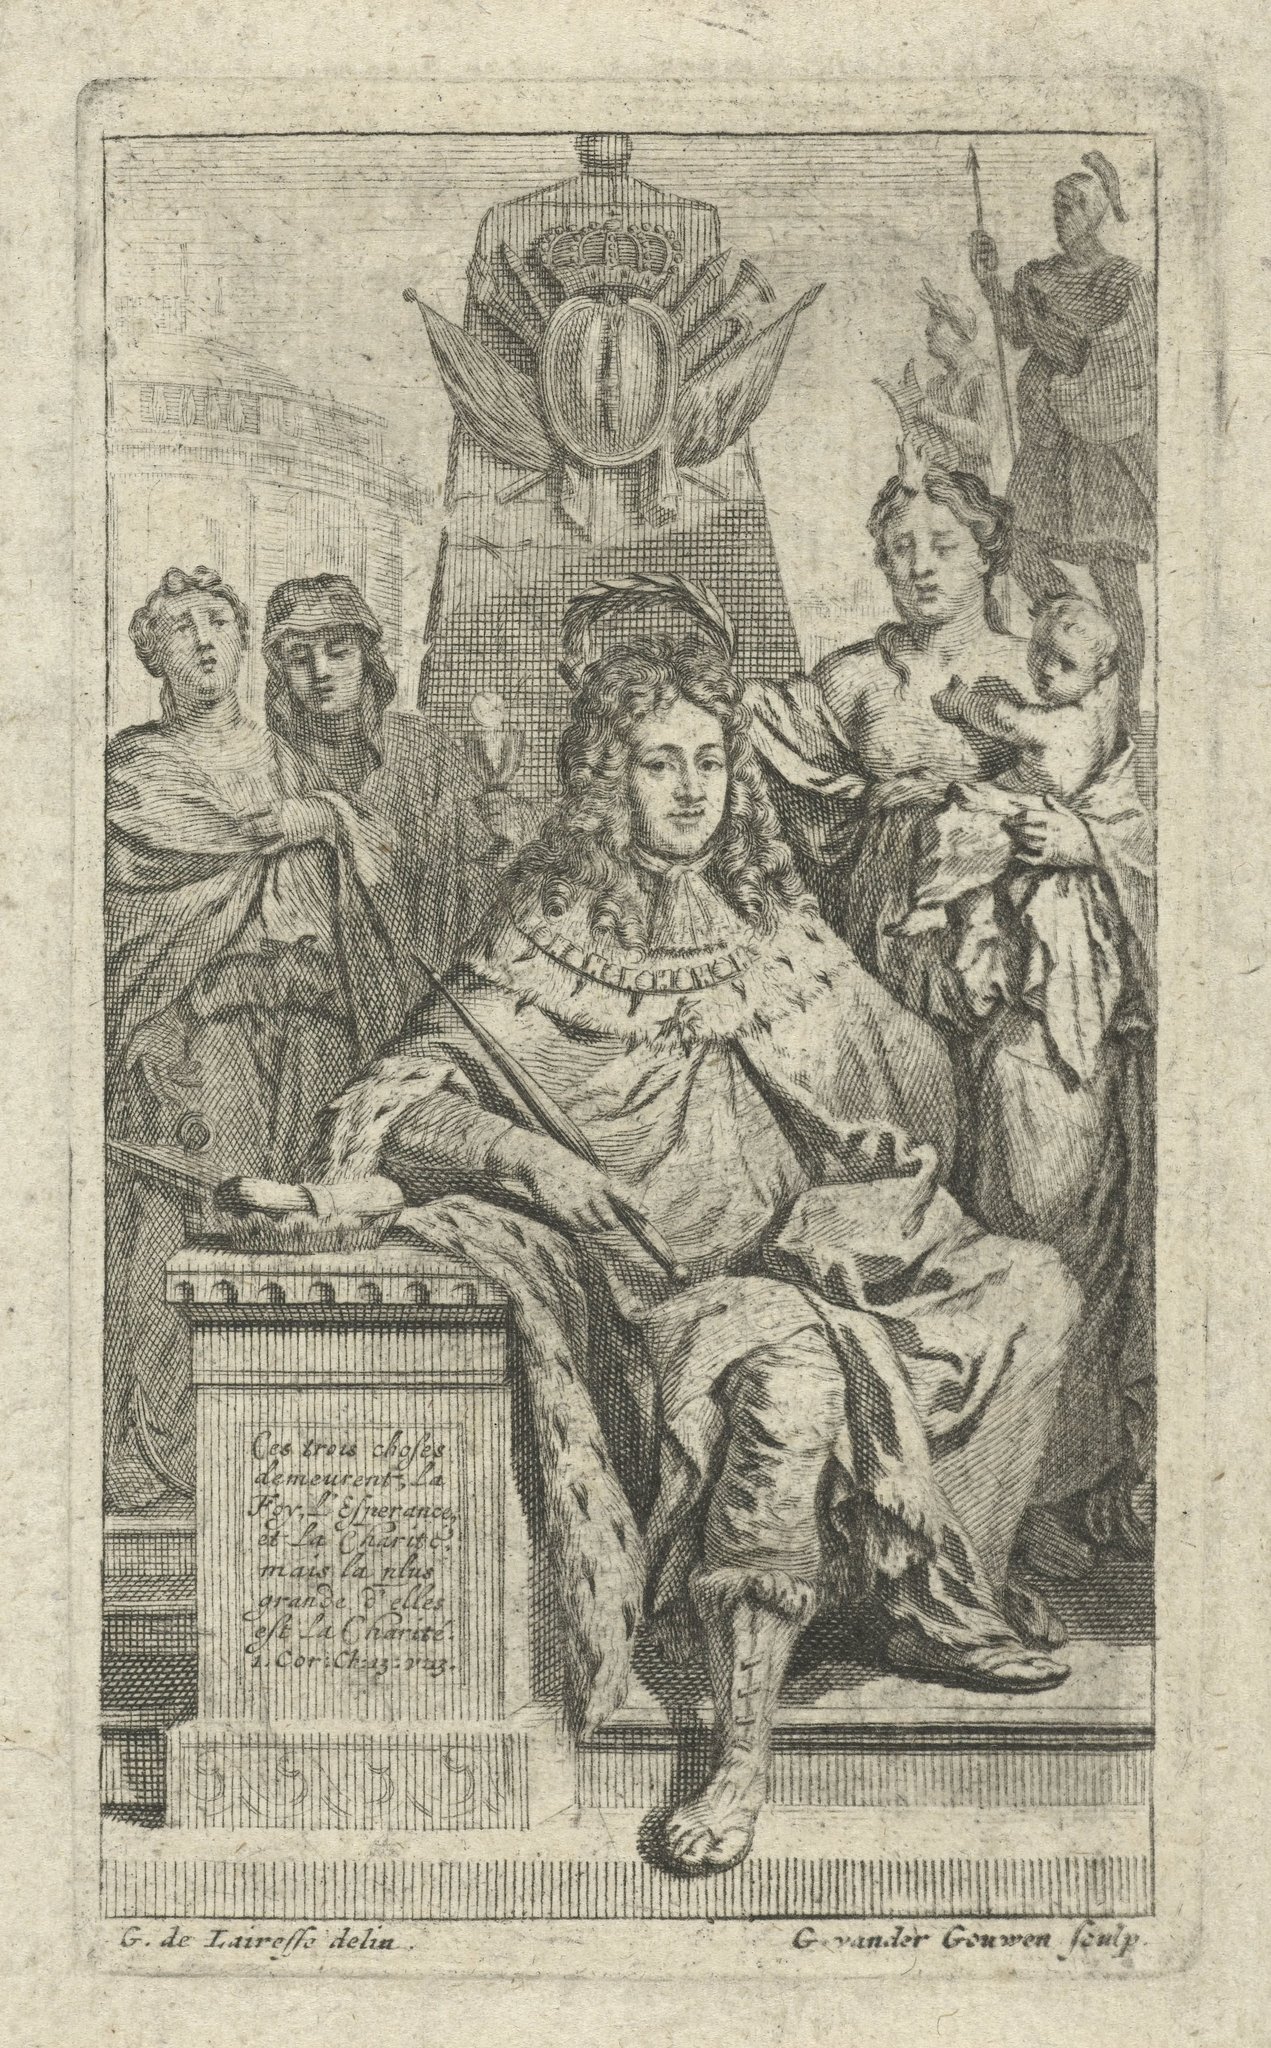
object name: print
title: Portret van Frederik I van Pruisen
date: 1688-1740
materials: paper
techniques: engraving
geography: amsterdam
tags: berlin, frederik i koning van pruisen, obelisk, needle, the three theological virtues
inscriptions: collector's mark: Lugt 2228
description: Frederik I van Pruisen zit leunend tegen een voetstuk met een Franse tekst. Hij wordt met een lauwerkrans gekroond door Liefde (Caritas), met een kind aan haar schouder en een vlam op haar hoofd. Op de achtergrond een monumentale obelisk en de personificaties Geloof (Fides) en Hoop (Spes).